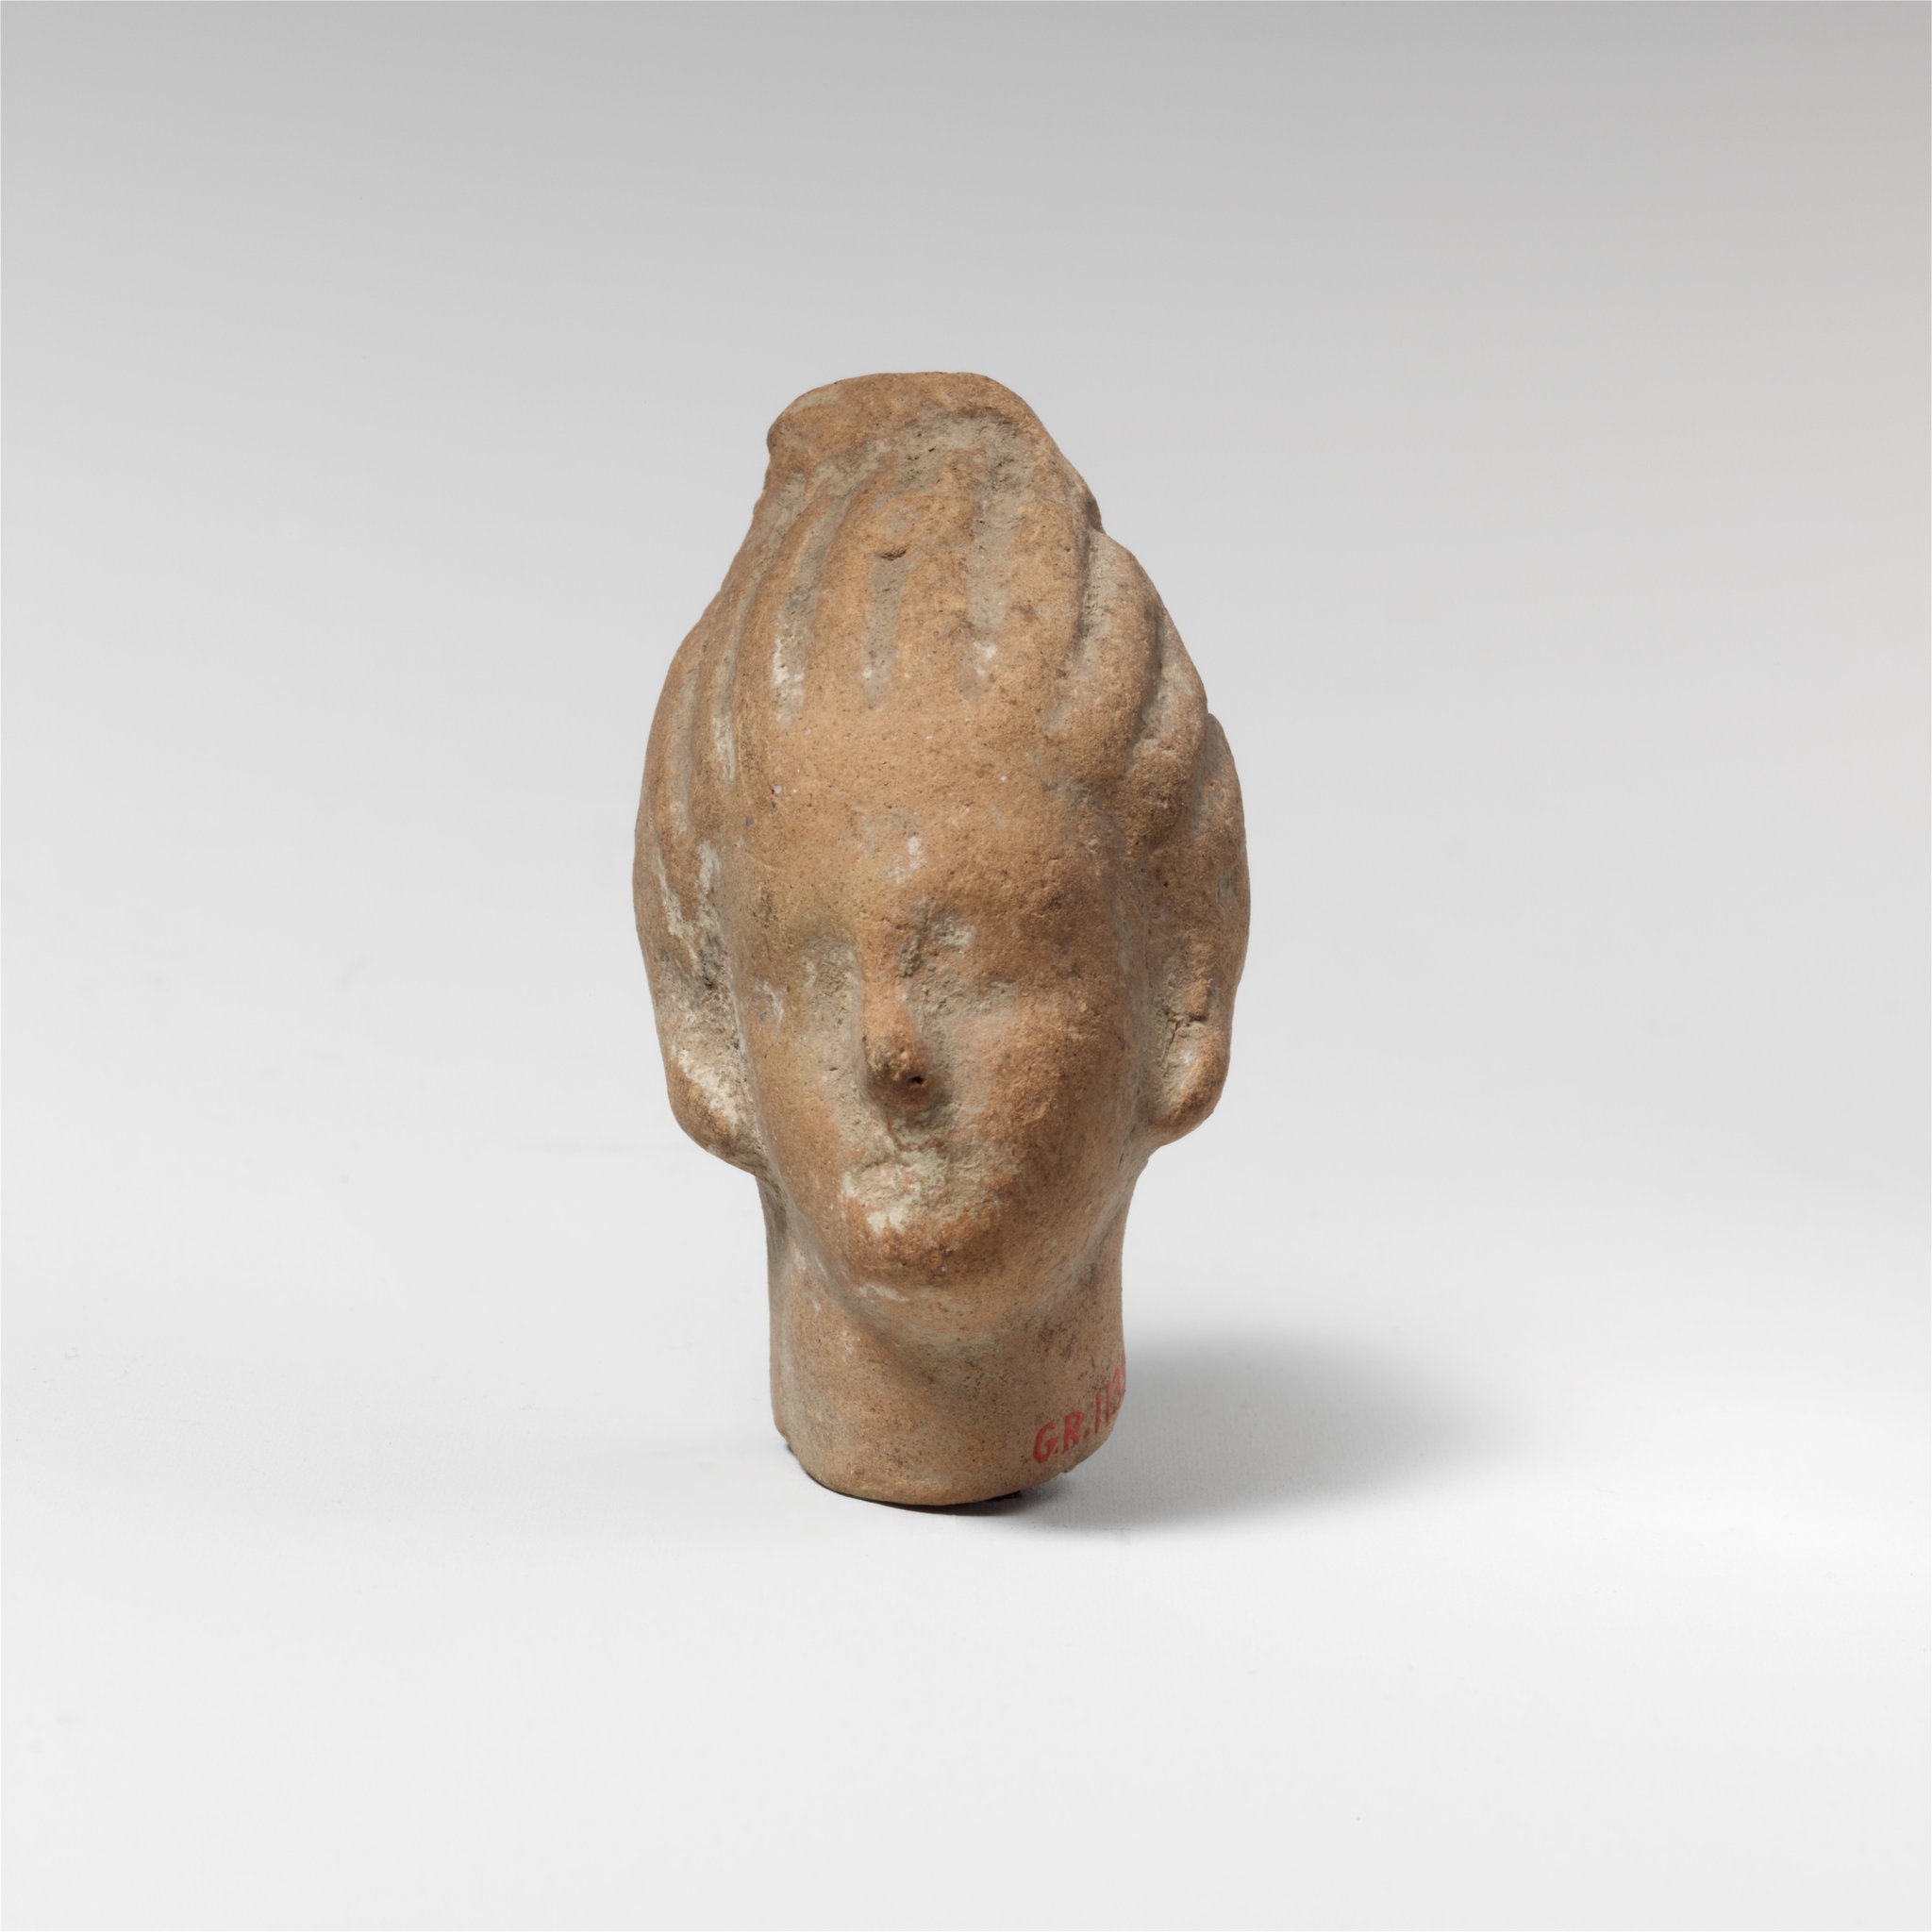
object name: head of a woman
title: Terracotta head of a woman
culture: egyptian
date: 300-101 BCE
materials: terracotta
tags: heads,women